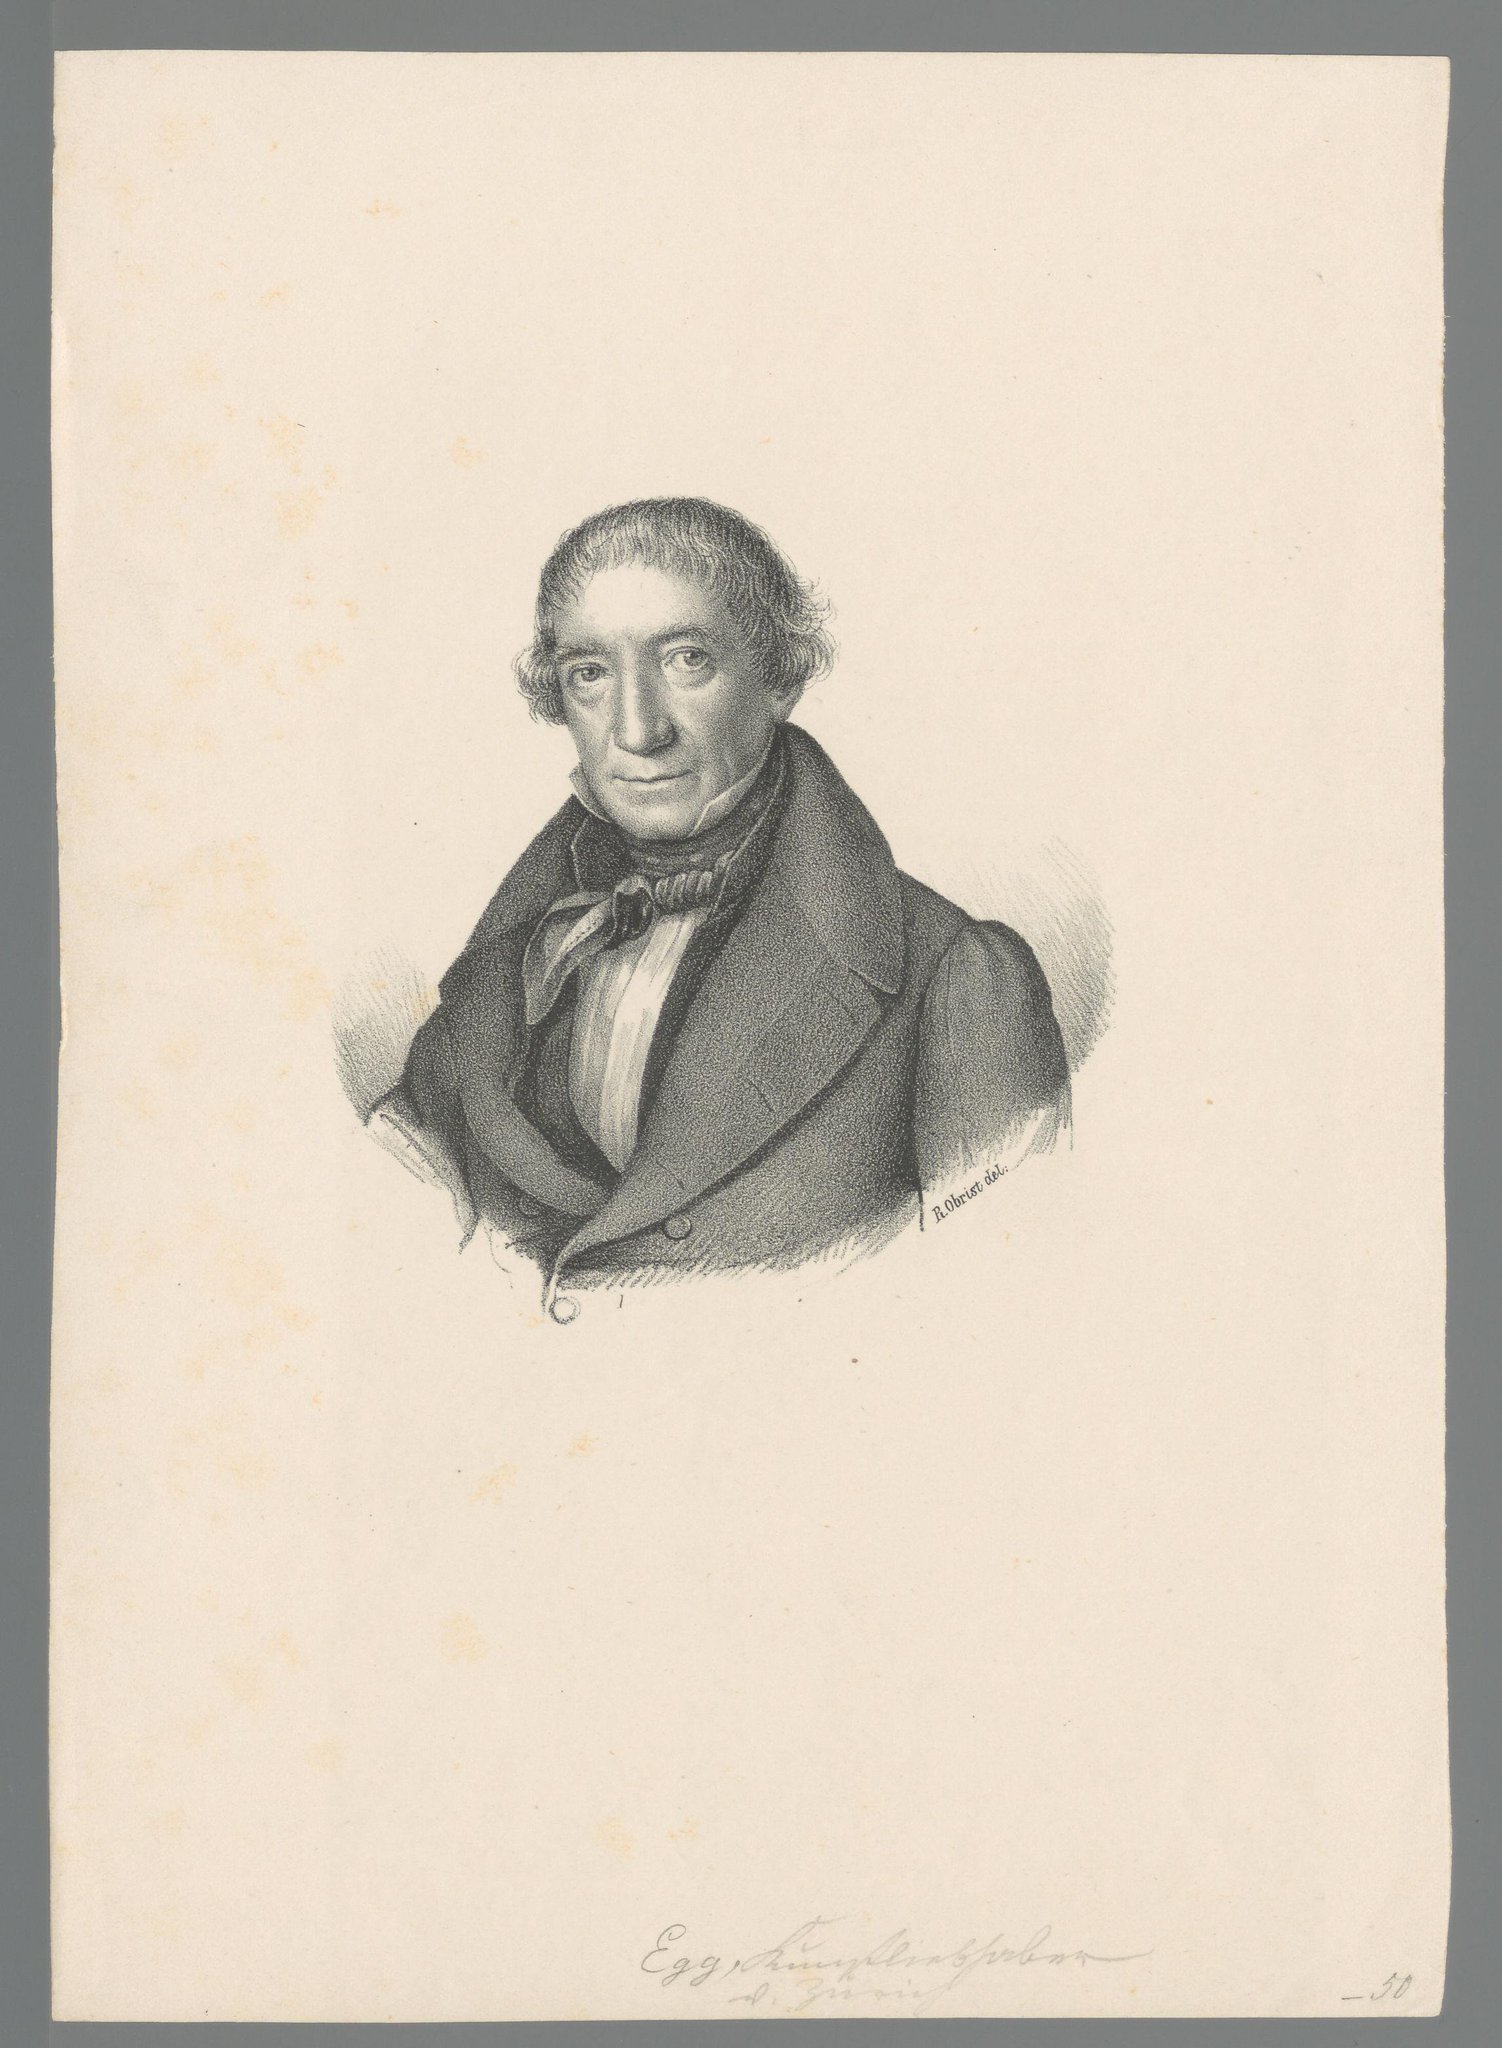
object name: print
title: Portret van een onbekende man, mogelijk Egg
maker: r. obrist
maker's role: print maker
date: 1820-1850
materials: paper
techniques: lithograph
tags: adult man, historical persons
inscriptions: collector's mark: Lugt 2228